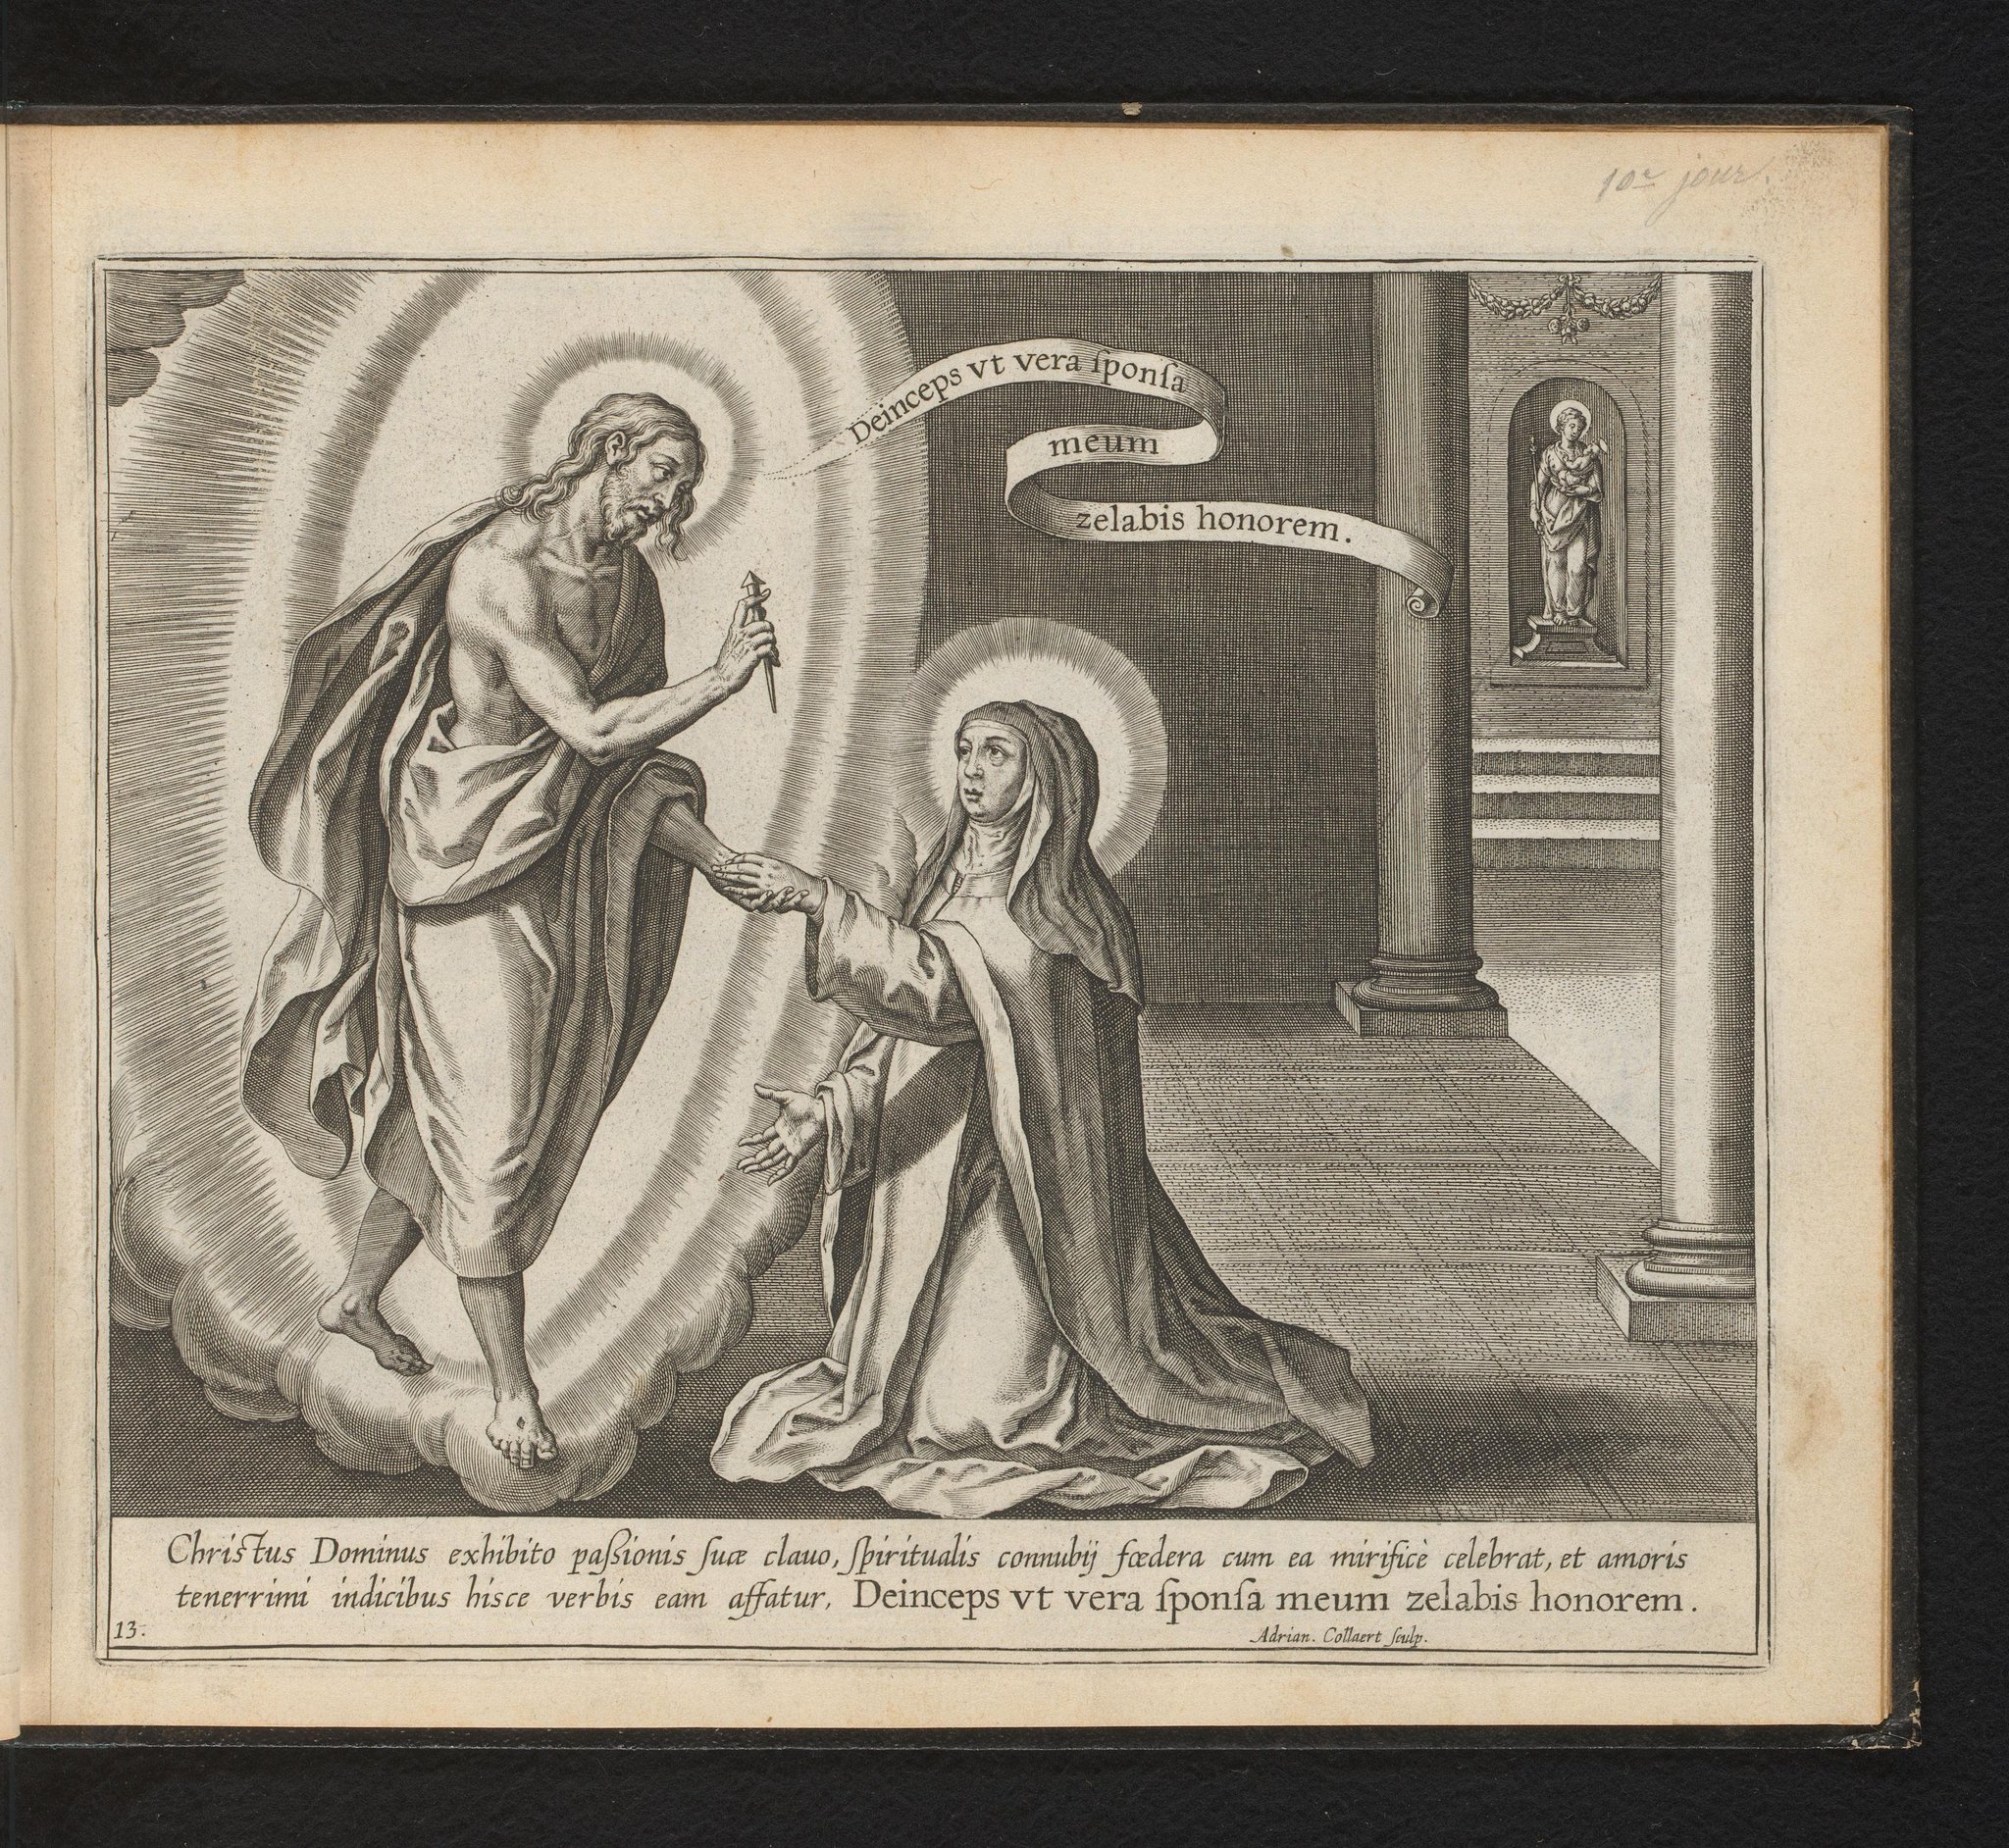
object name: print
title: Christus toont aan de H. Theresa de nagel van het kruis; zij wordt zijn geestelijke bruid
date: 1613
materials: paper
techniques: engraving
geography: antwerp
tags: christ appears to st. theresa and gives her a nail of the cross (so-called mystic marriage)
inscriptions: caption: ‘Christus Dominus exhibito...zelabis honorem.’, number: ‘13’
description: Prent in album 'Vita B. Virginis Teresiae A. Jesu ordinis carmelitarum excalceatorum piae restauratricis..., 1613.